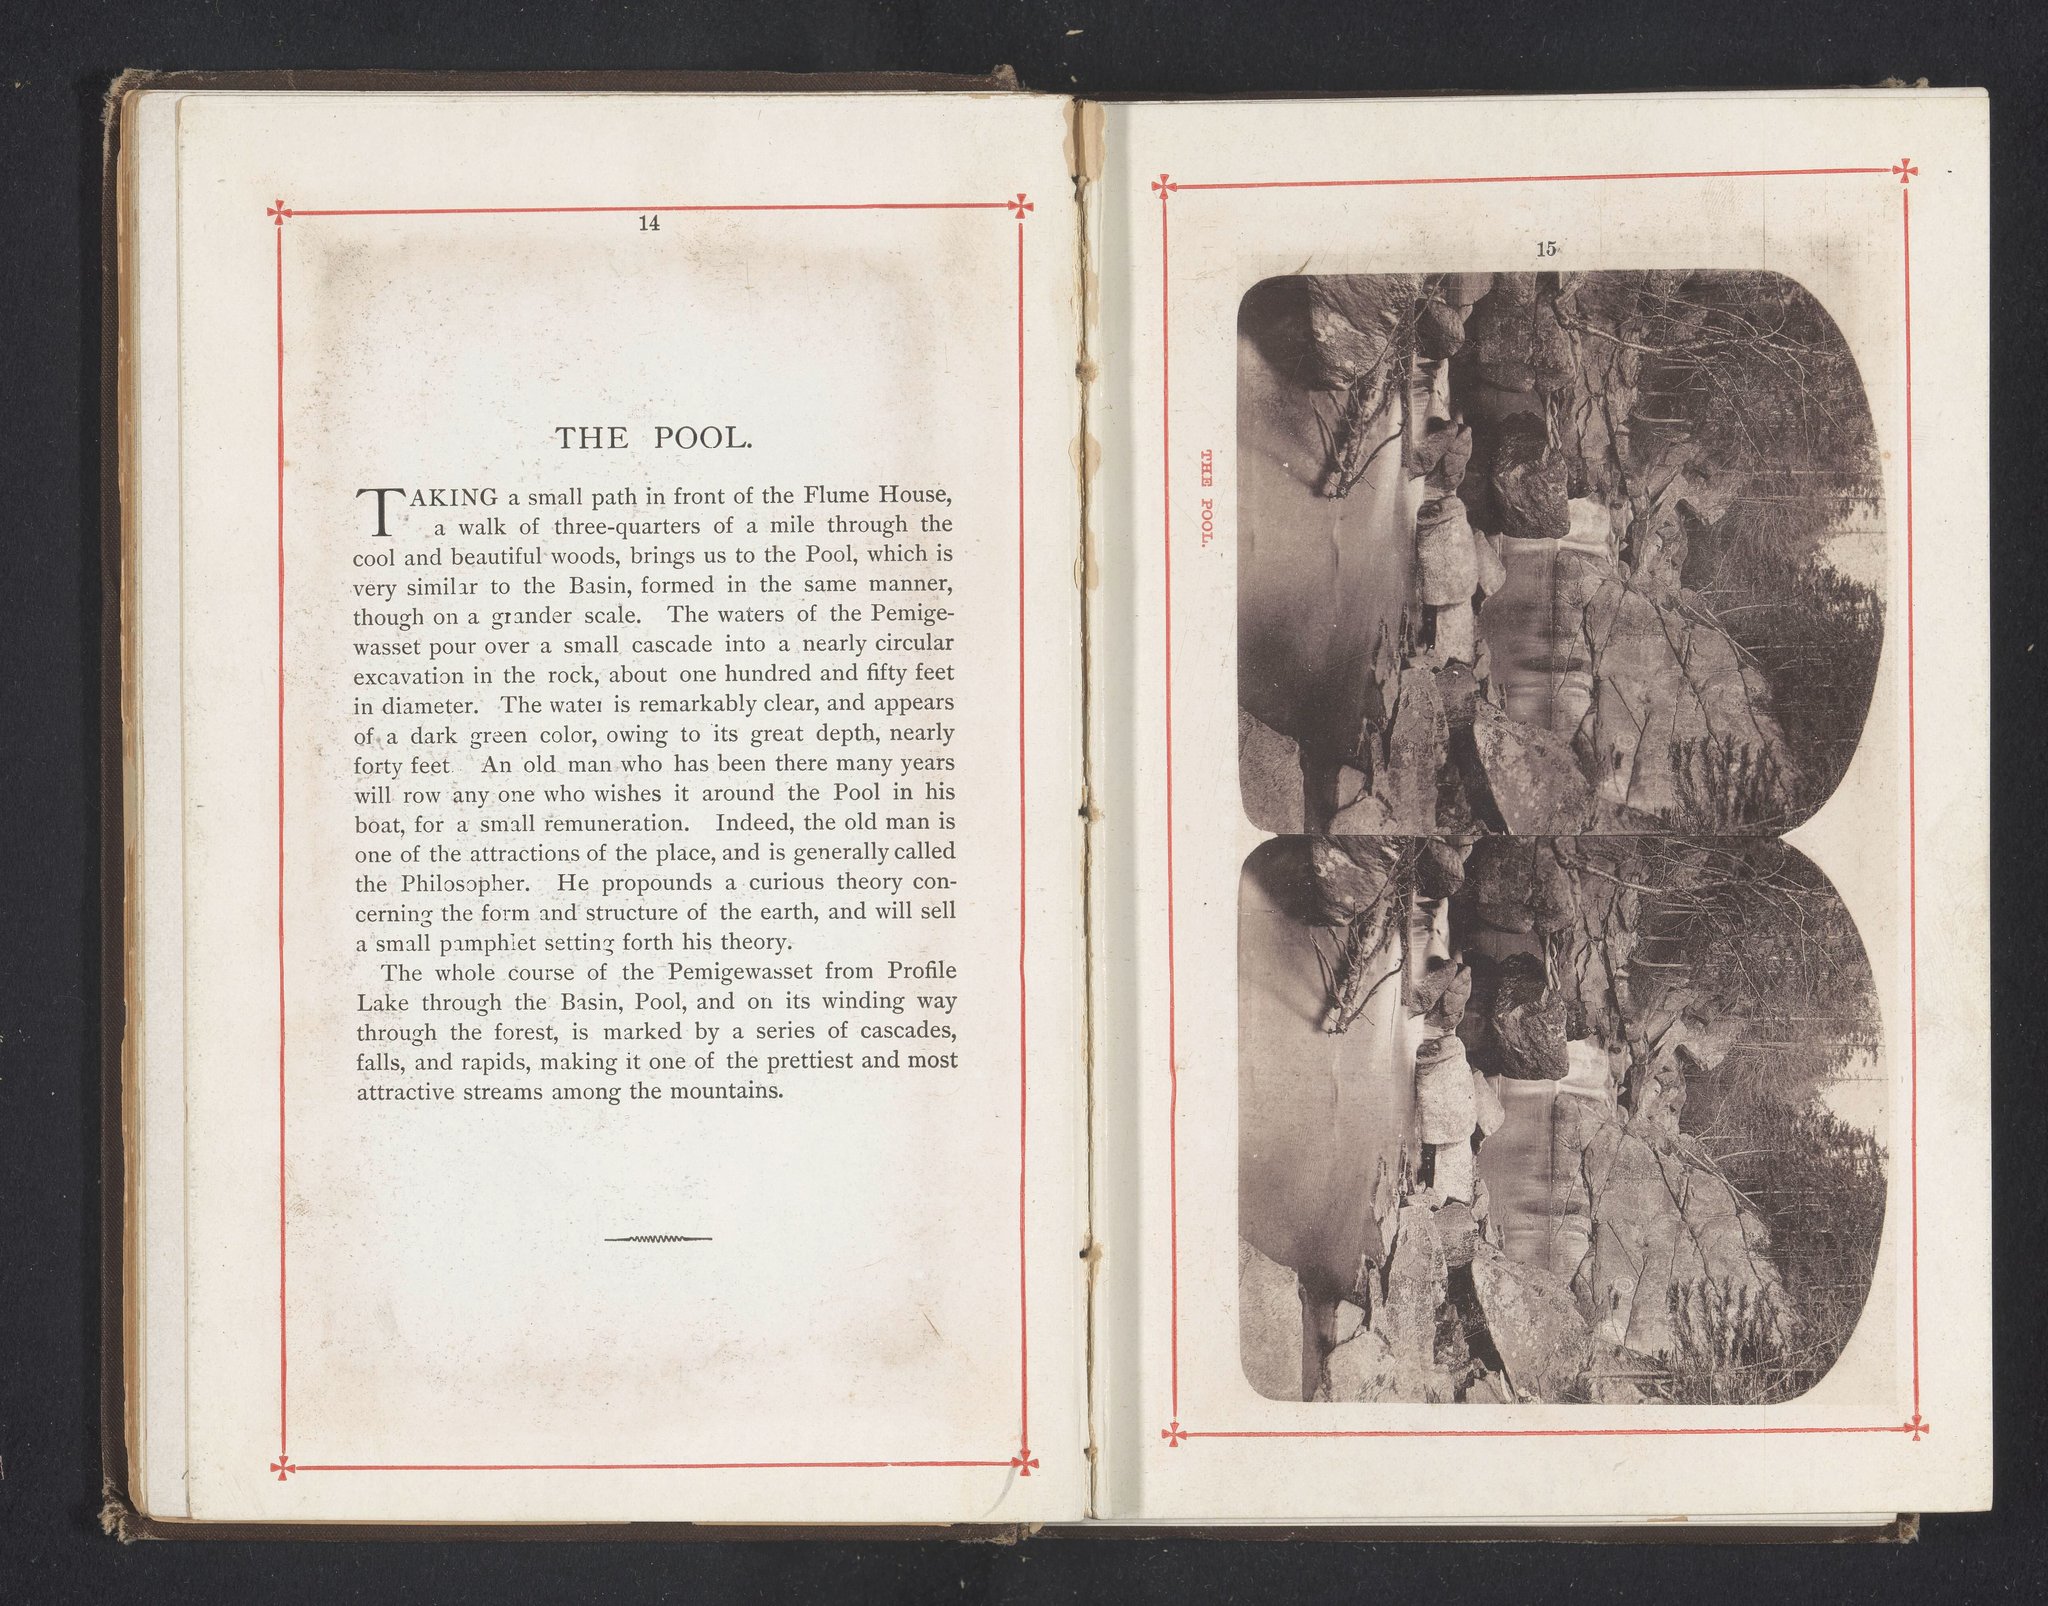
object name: photomechanical print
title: Gezicht op een waterval in het Franconia Notch State Park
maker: Anonymous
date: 1873-1878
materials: paper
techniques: photograph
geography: franconia notch state park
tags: trees, waterfall, pond, pool